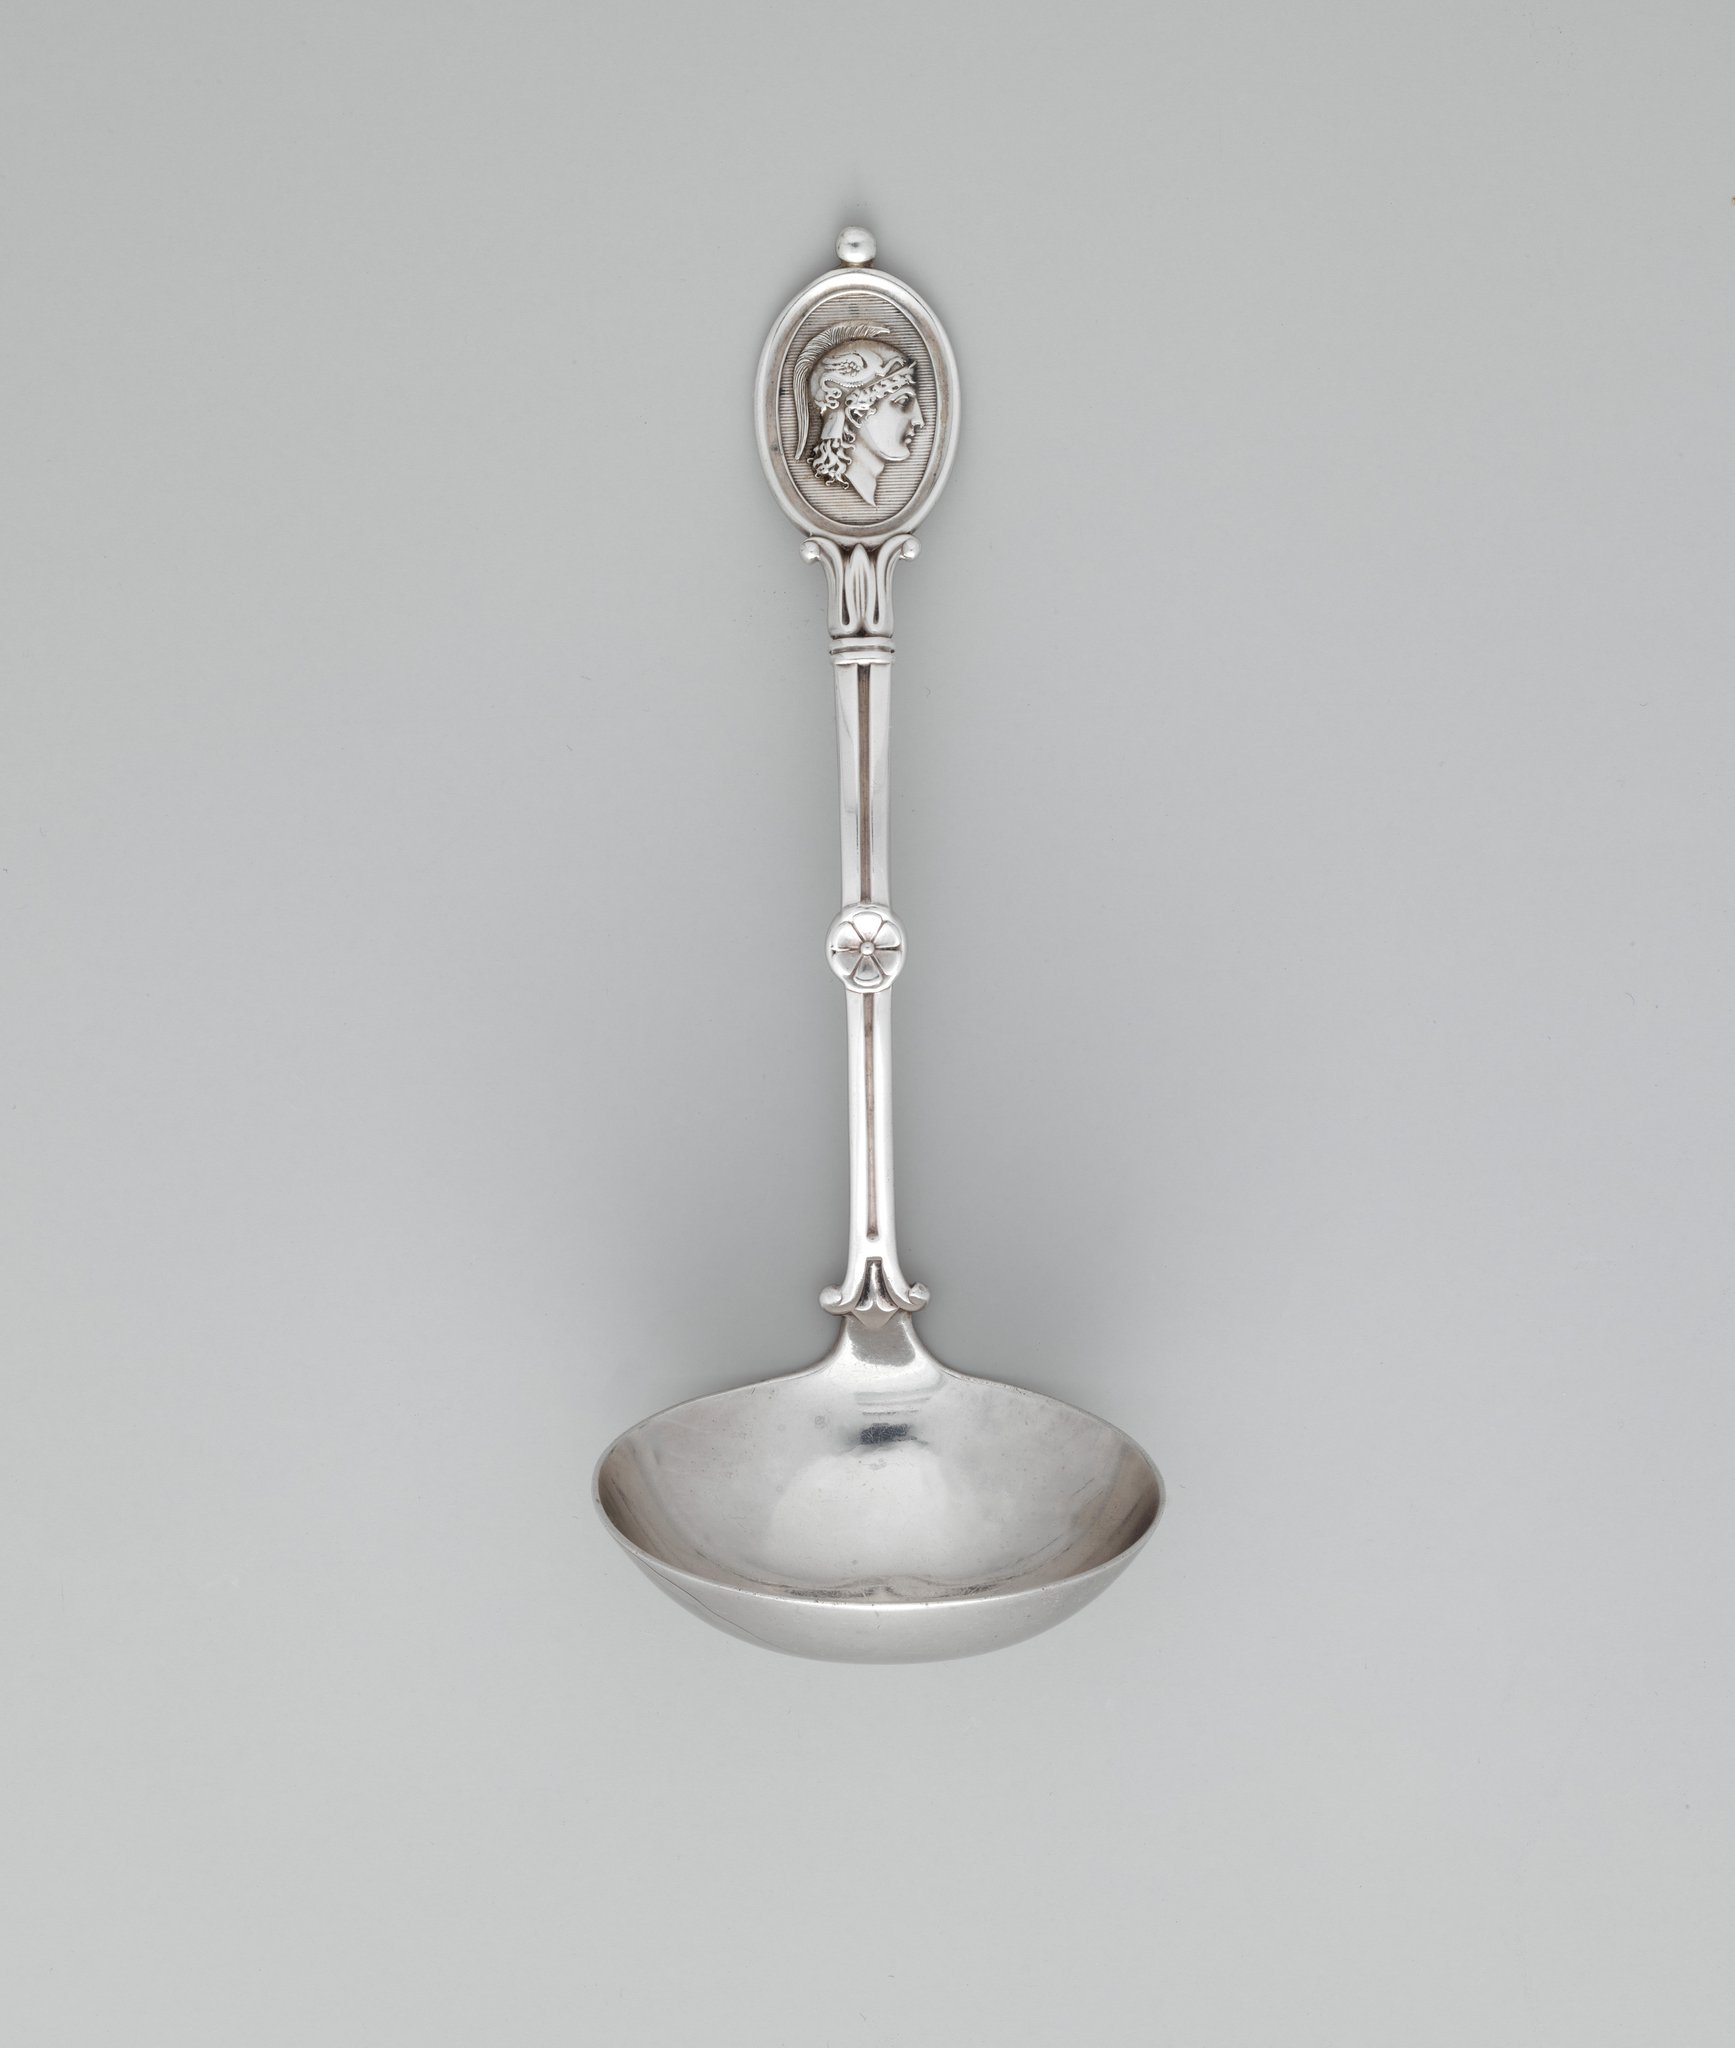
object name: ladle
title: Sauce Ladle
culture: american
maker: john r. wendt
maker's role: maker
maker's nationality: american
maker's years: 1826-1907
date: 1862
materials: silver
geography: united states